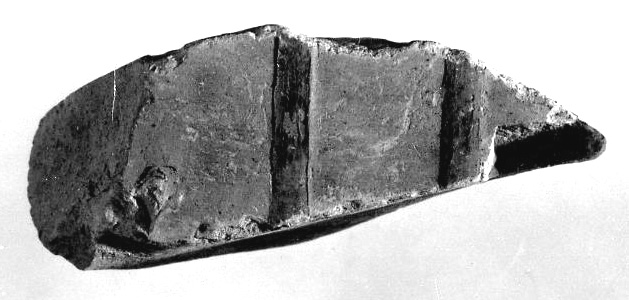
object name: relief fragment, tomb of meketre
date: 1981-1975 BCE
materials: limestone, paint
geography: egypt